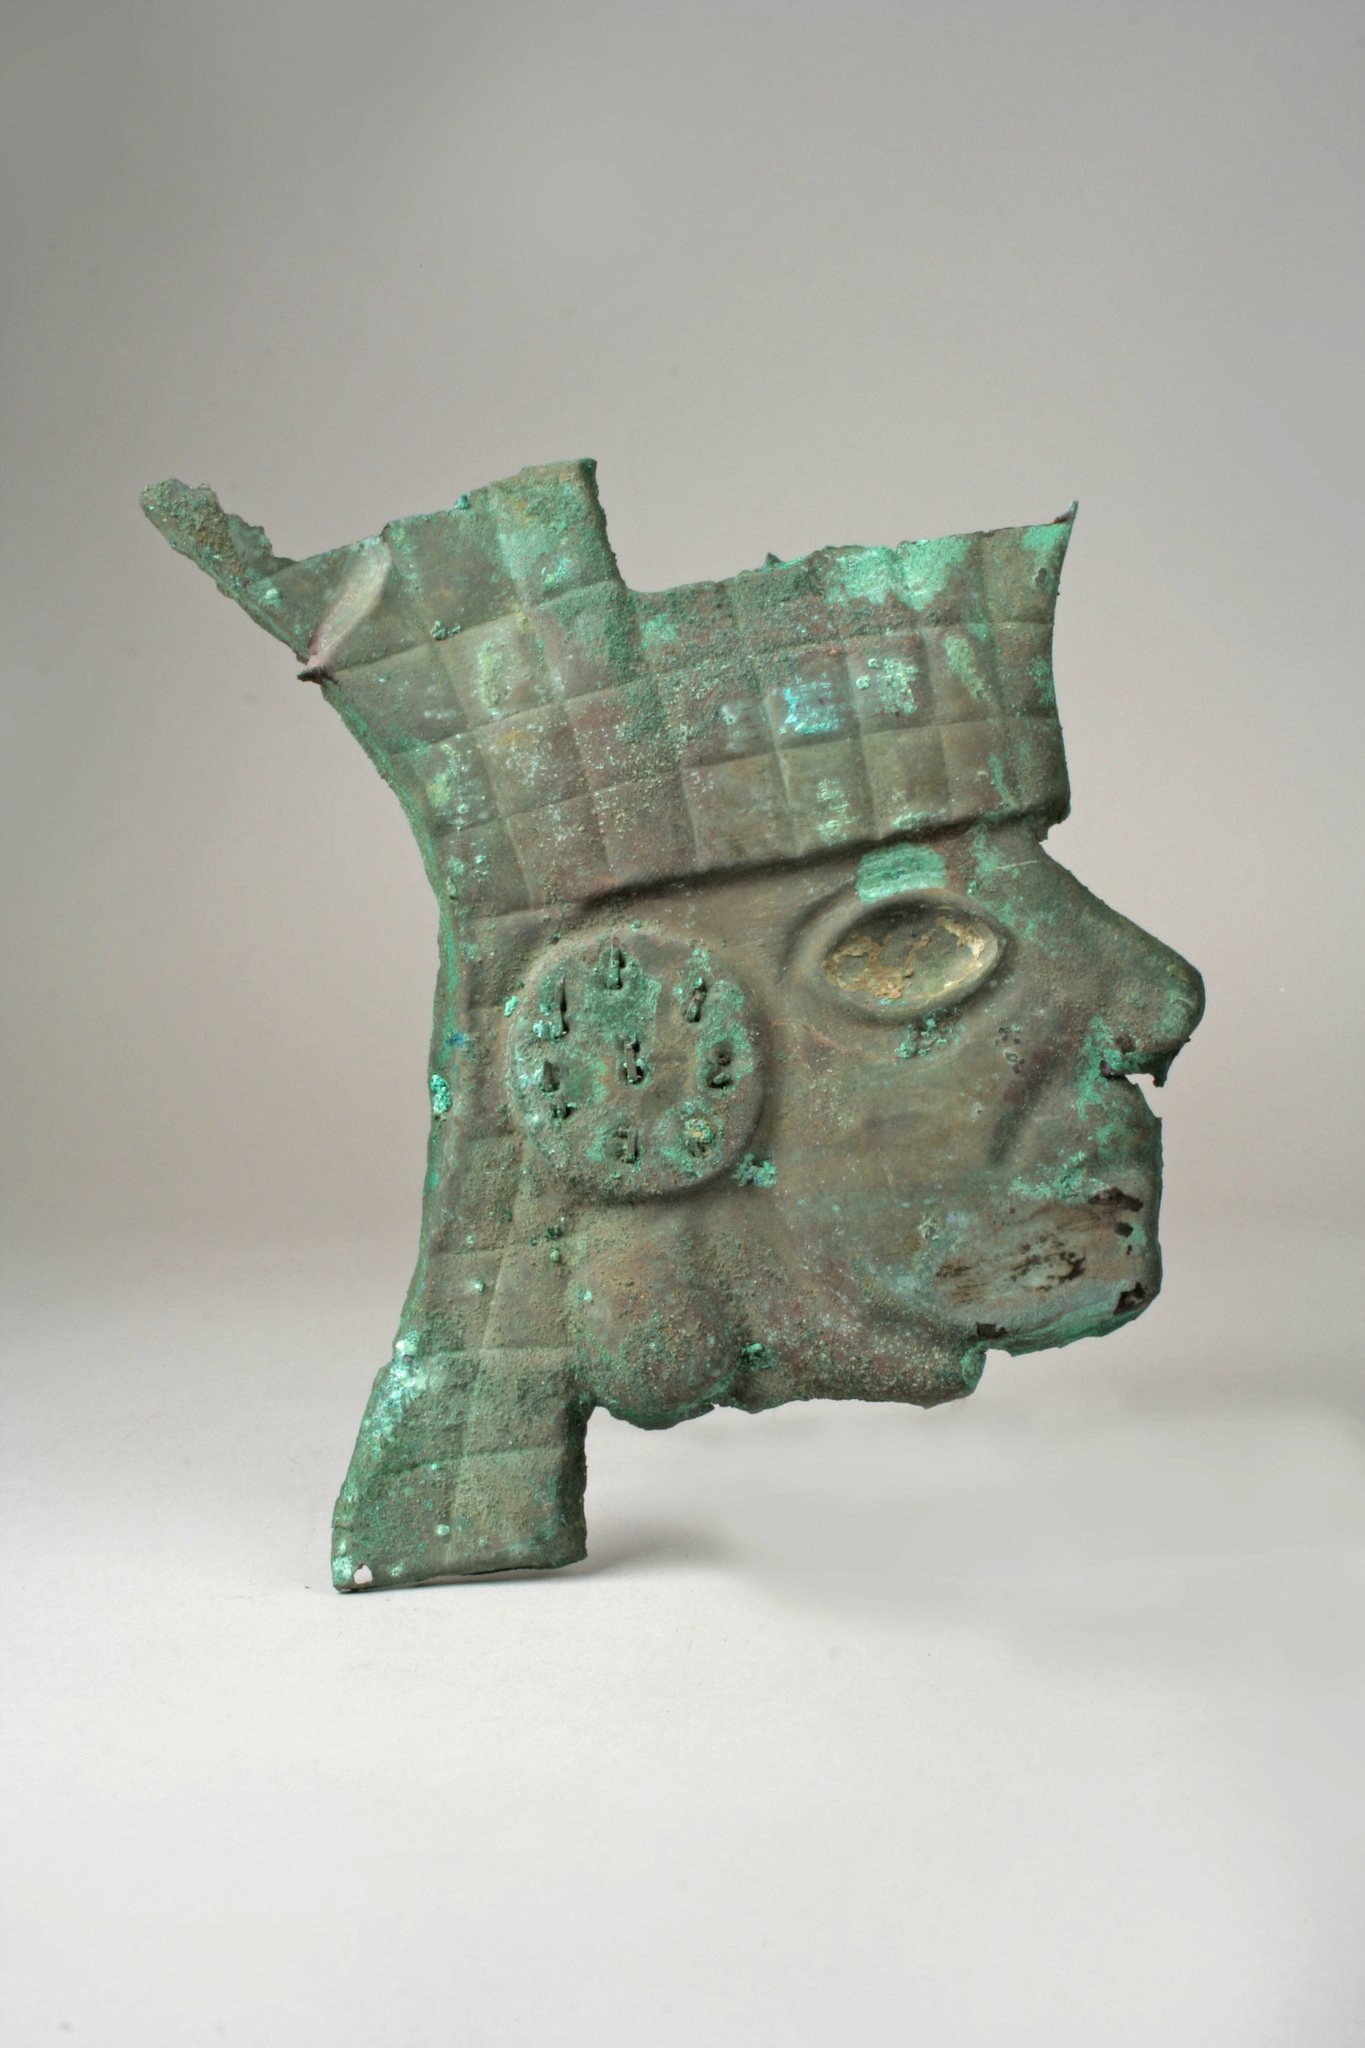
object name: ornament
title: Profile Warrior Face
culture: moche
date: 501-700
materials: metal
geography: peru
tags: profiles,warriors